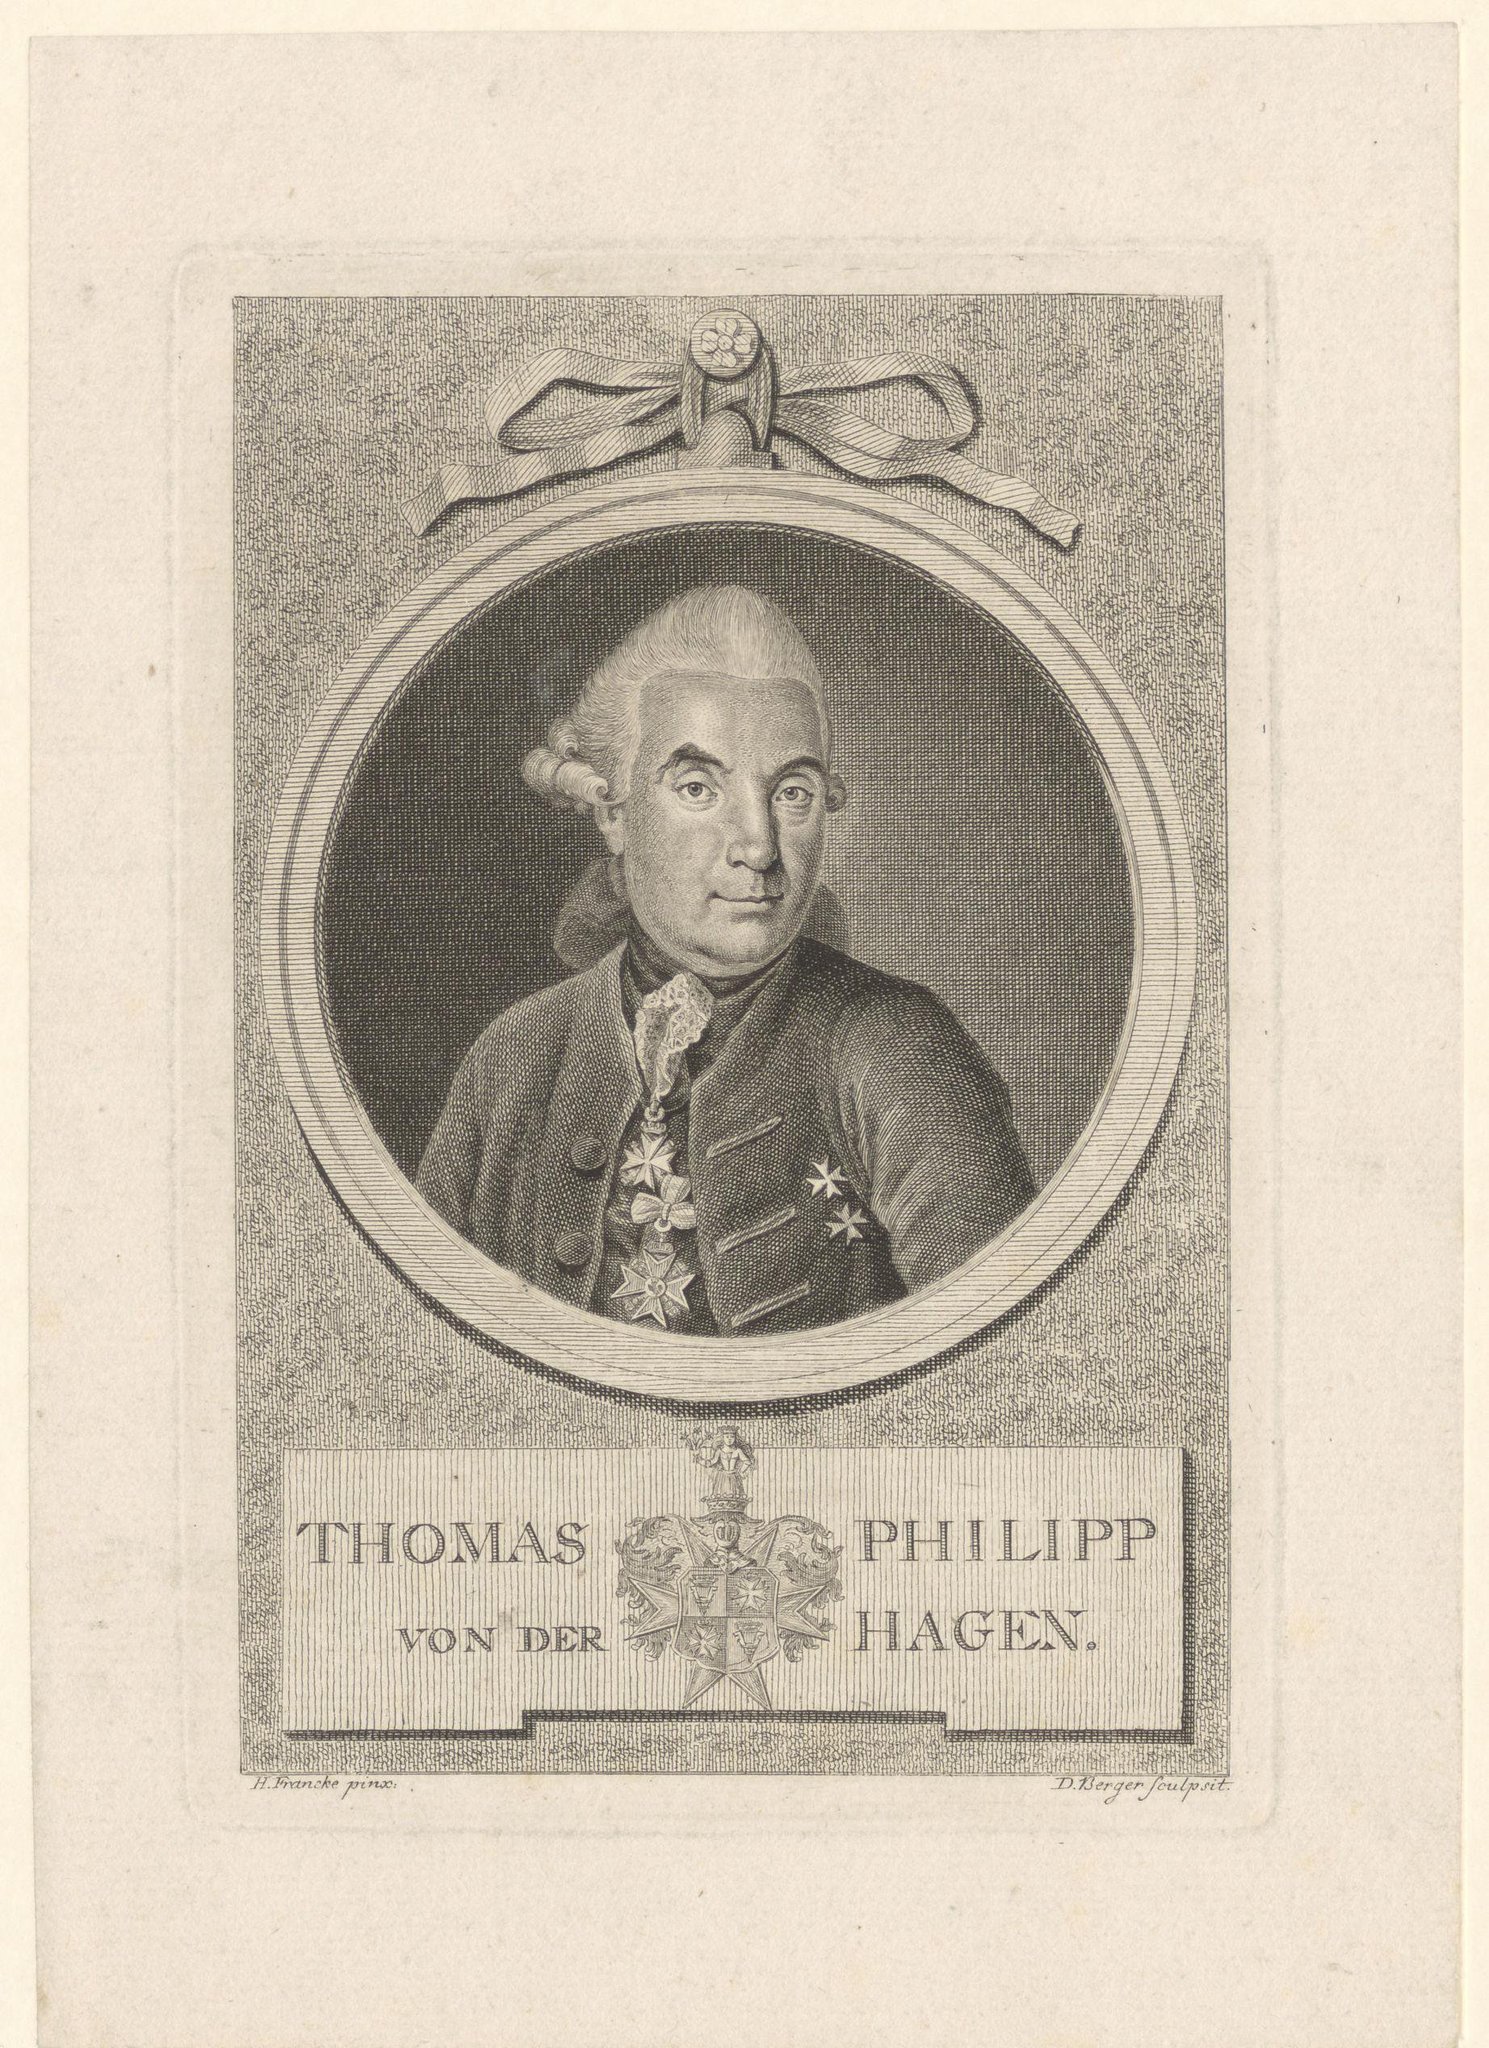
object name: print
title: Portret van Thomas Philipp von der Hagen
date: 1778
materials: paper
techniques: engraving, etching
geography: berlin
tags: berlin, historical persons, armorial bearing, heraldry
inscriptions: collector's mark: Lugt 2228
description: Prent ook gebruikt in: Krünitz, Johann Georg. Oeconomische Encyclopädie. dl. 15 Berlijn: Joachim Pauli, 1776.